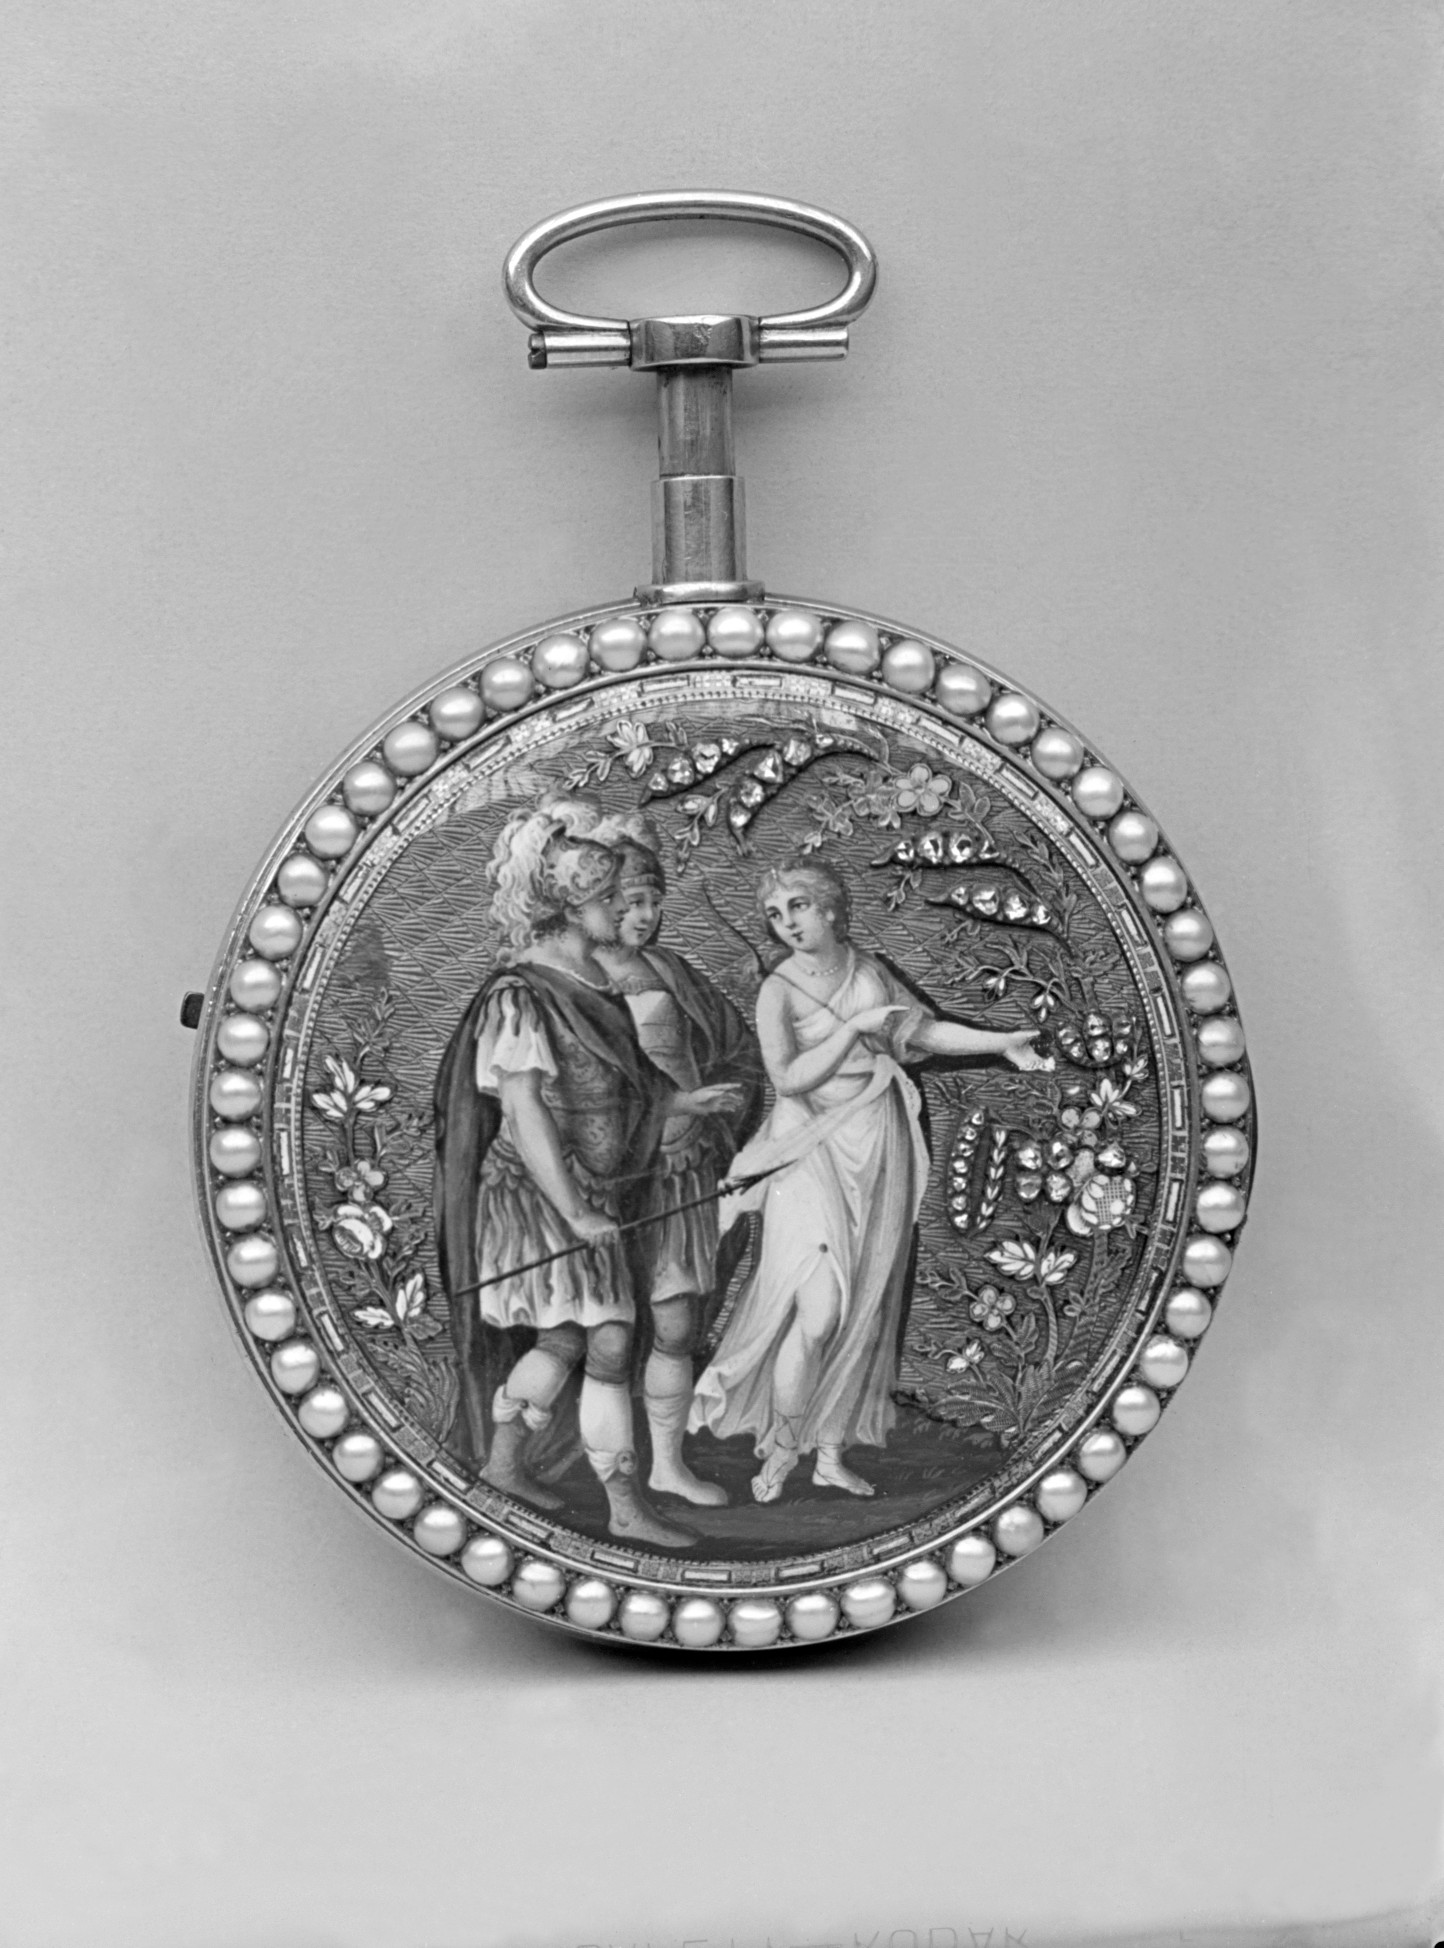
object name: repeating watch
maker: george achard et fils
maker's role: maker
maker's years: 1775-1785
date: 1767-1800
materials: enamel, gold, pearl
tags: spears,men,women,flowers